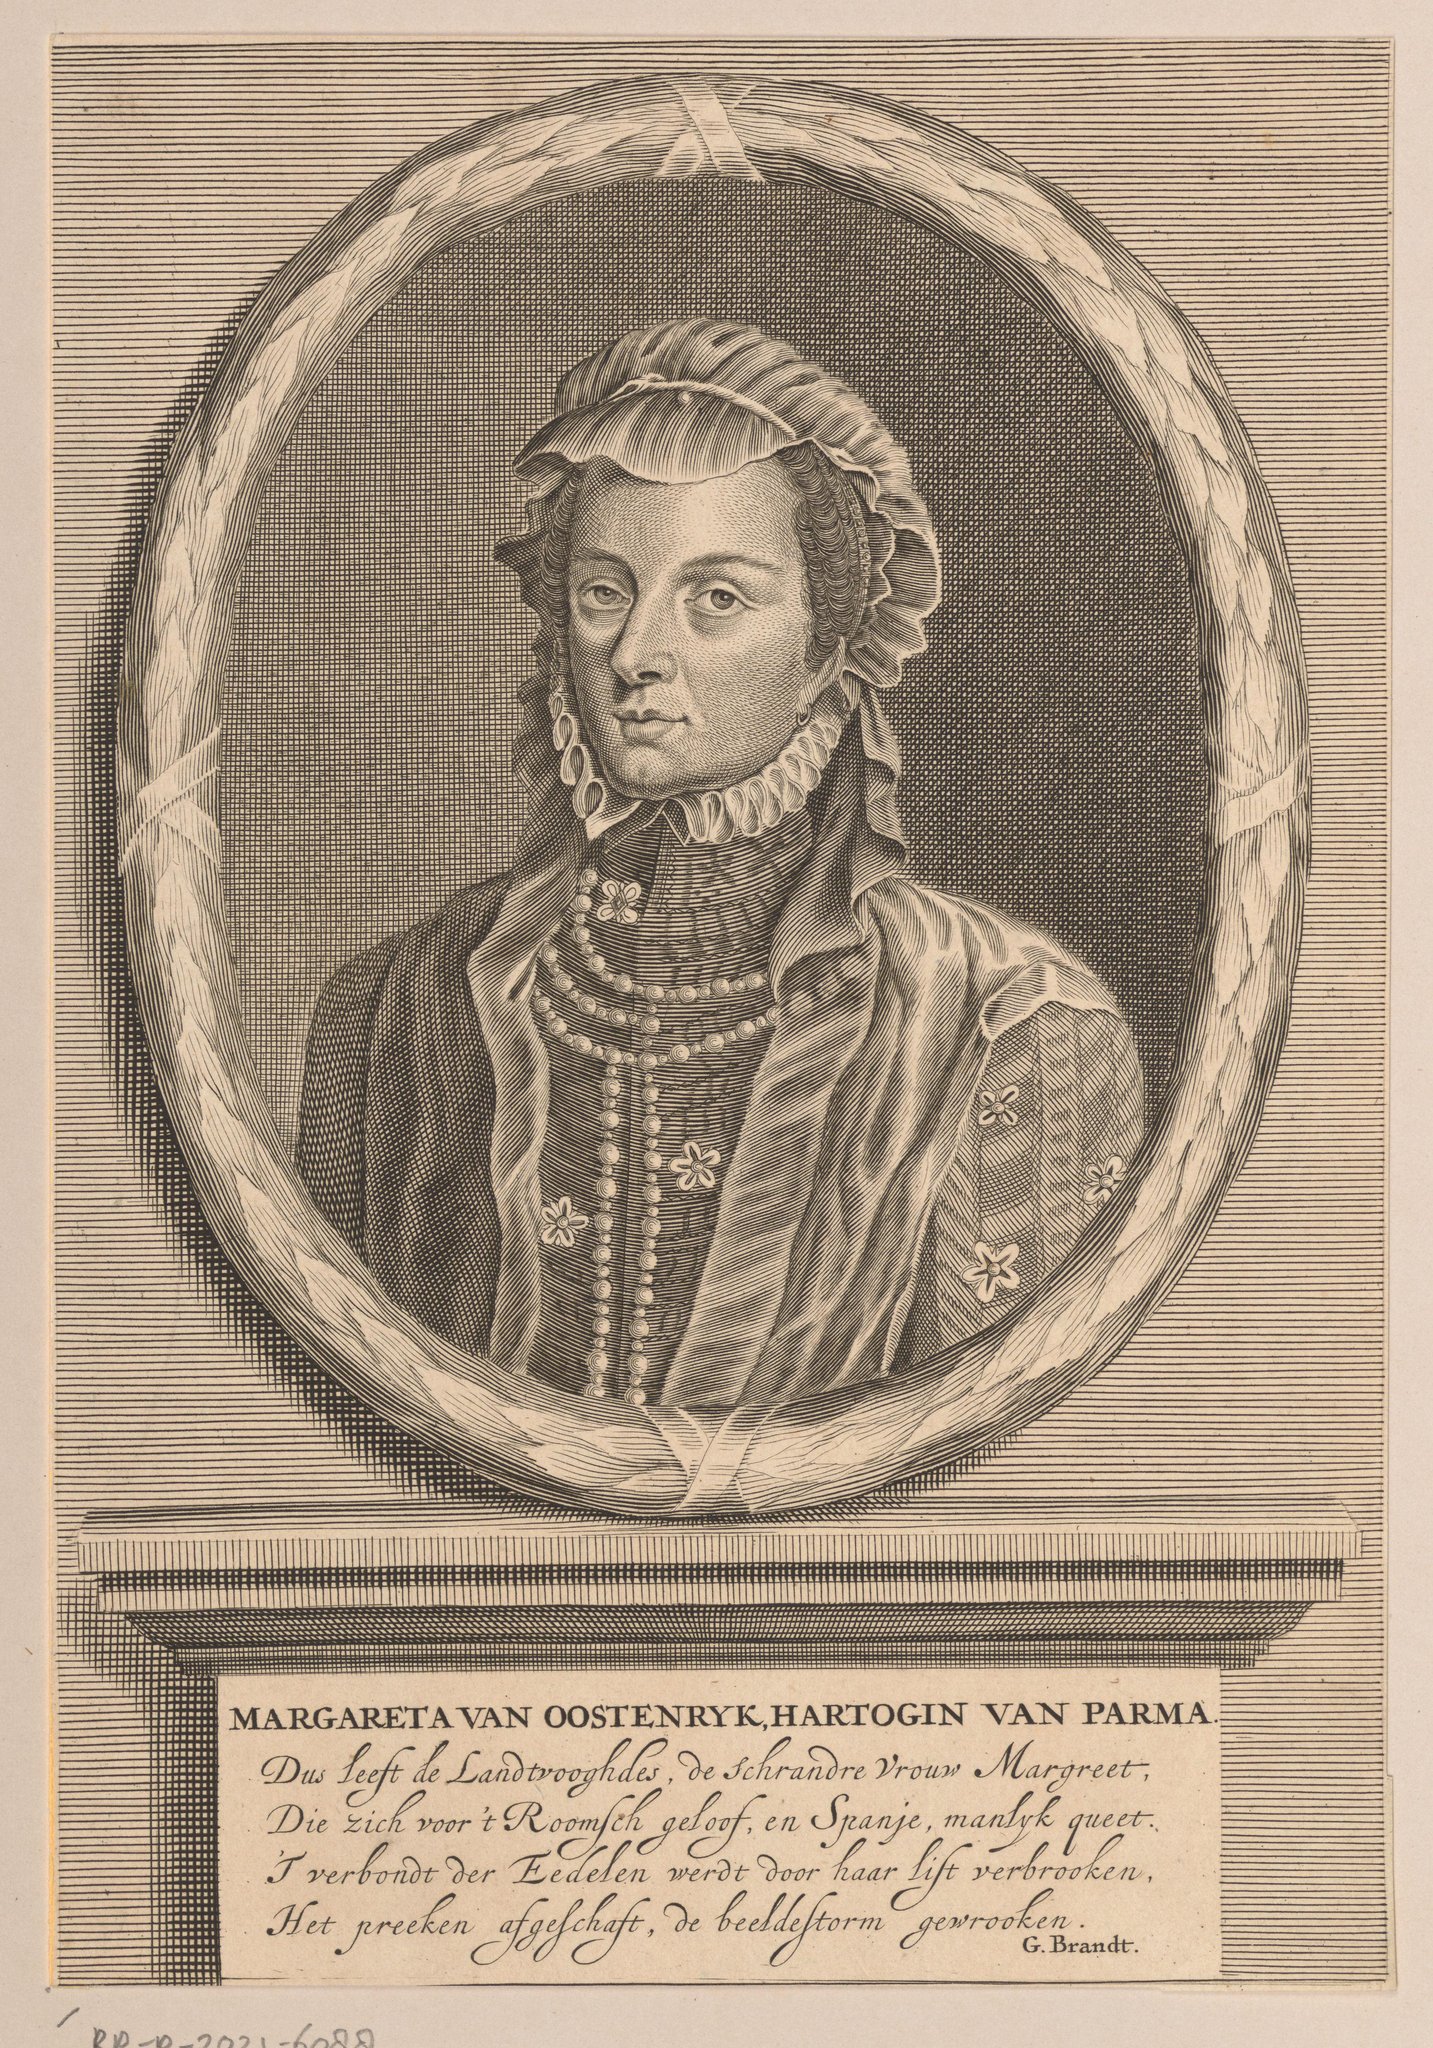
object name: book illustration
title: Portret van Margaretha van Parma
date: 1677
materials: paper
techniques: engraving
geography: northern netherlands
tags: historical persons - bb - woman, ornament ~ medallion, regent, substitute ruler; viceroy - bb - female ruler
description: Prent waarschijnlijk uit: Hooft, P.C. Nederlandsche Historien (...). Amsterdam: Johan van Someren et al., 1677. Latere staten zijn gebruikt in publicaties uit 1679, 1690 en 1730.